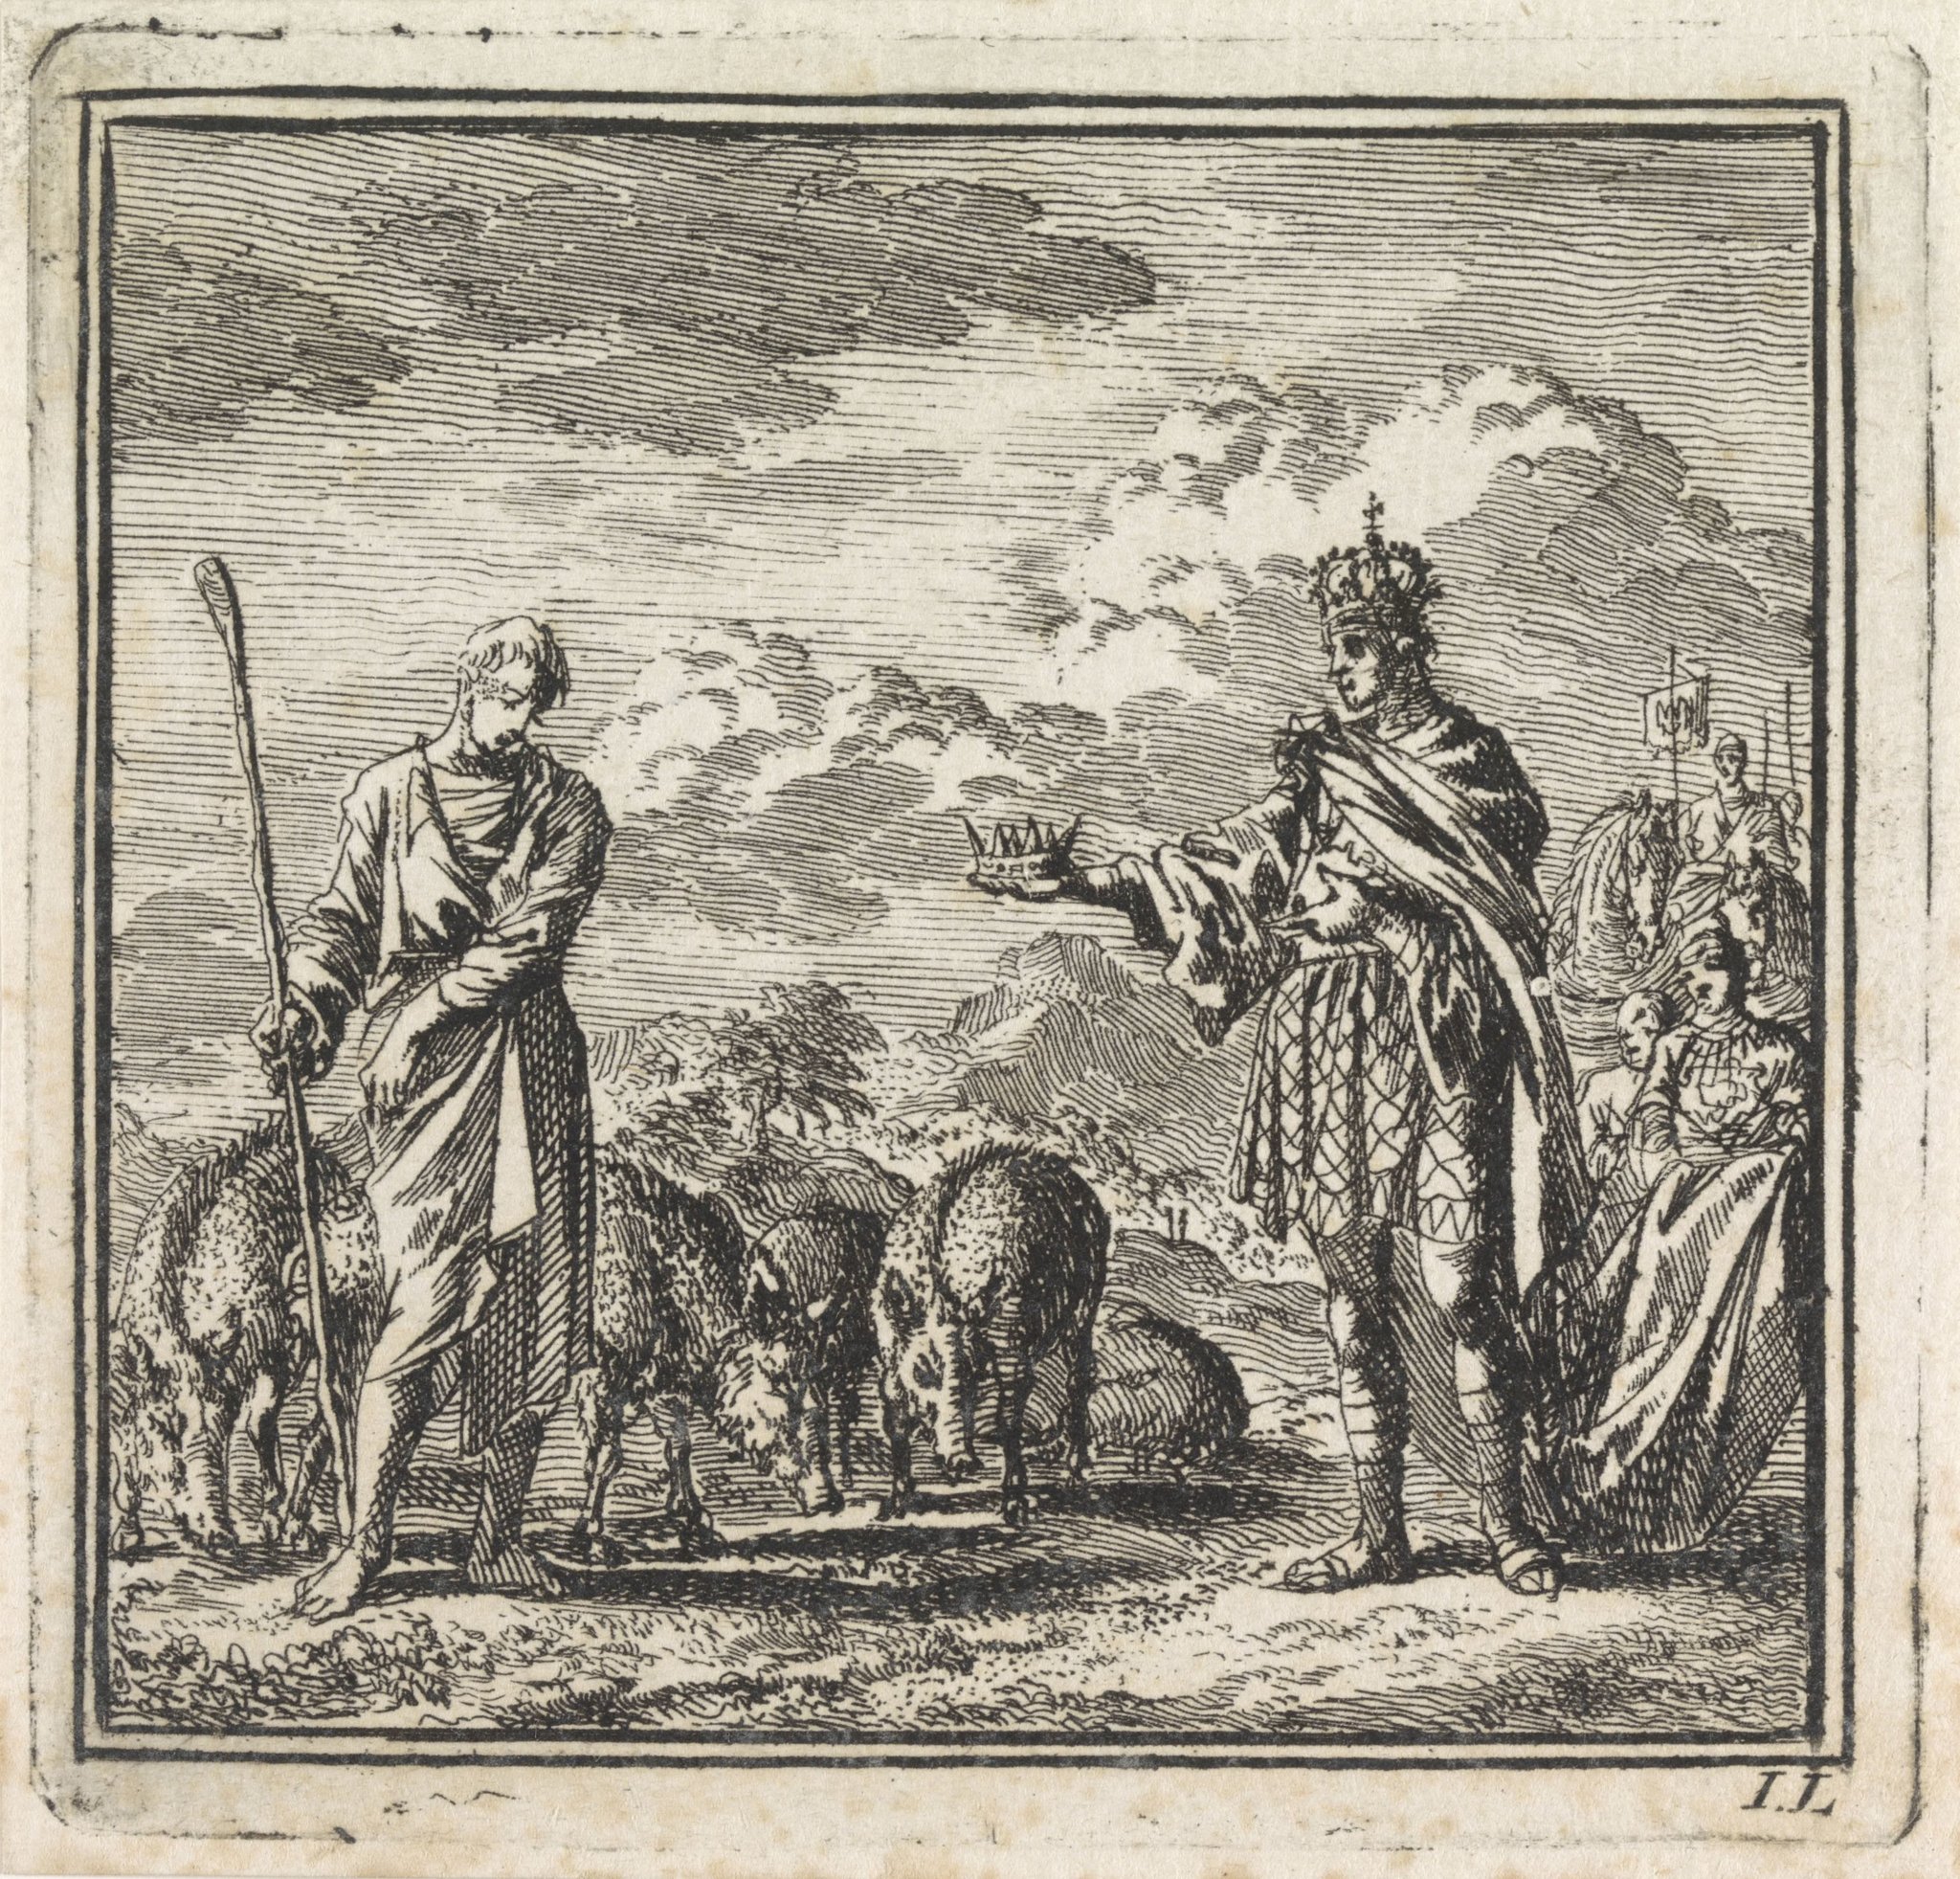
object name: book illustration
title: Zwijnenboer wijgert de kroon die hem wordt aangeboeden door een koning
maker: jan luyken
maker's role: draughtsman, print maker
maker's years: 1649-1712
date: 1710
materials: paper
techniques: etching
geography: amsterdam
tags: crown (symbol of sovereignty), pig, ruler, sovereign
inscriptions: collector's mark: Lugt 2228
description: Illustratie uit: Luyken, Jan. De onwaardige wereld, vertoond in vyftig zinnebeelden, met godlyke spreuken en stichtelyke verzen. Amsterdam: Pieter Arentsz. II (wed.) en Cornelis van der Sys, 1710, p. 102.